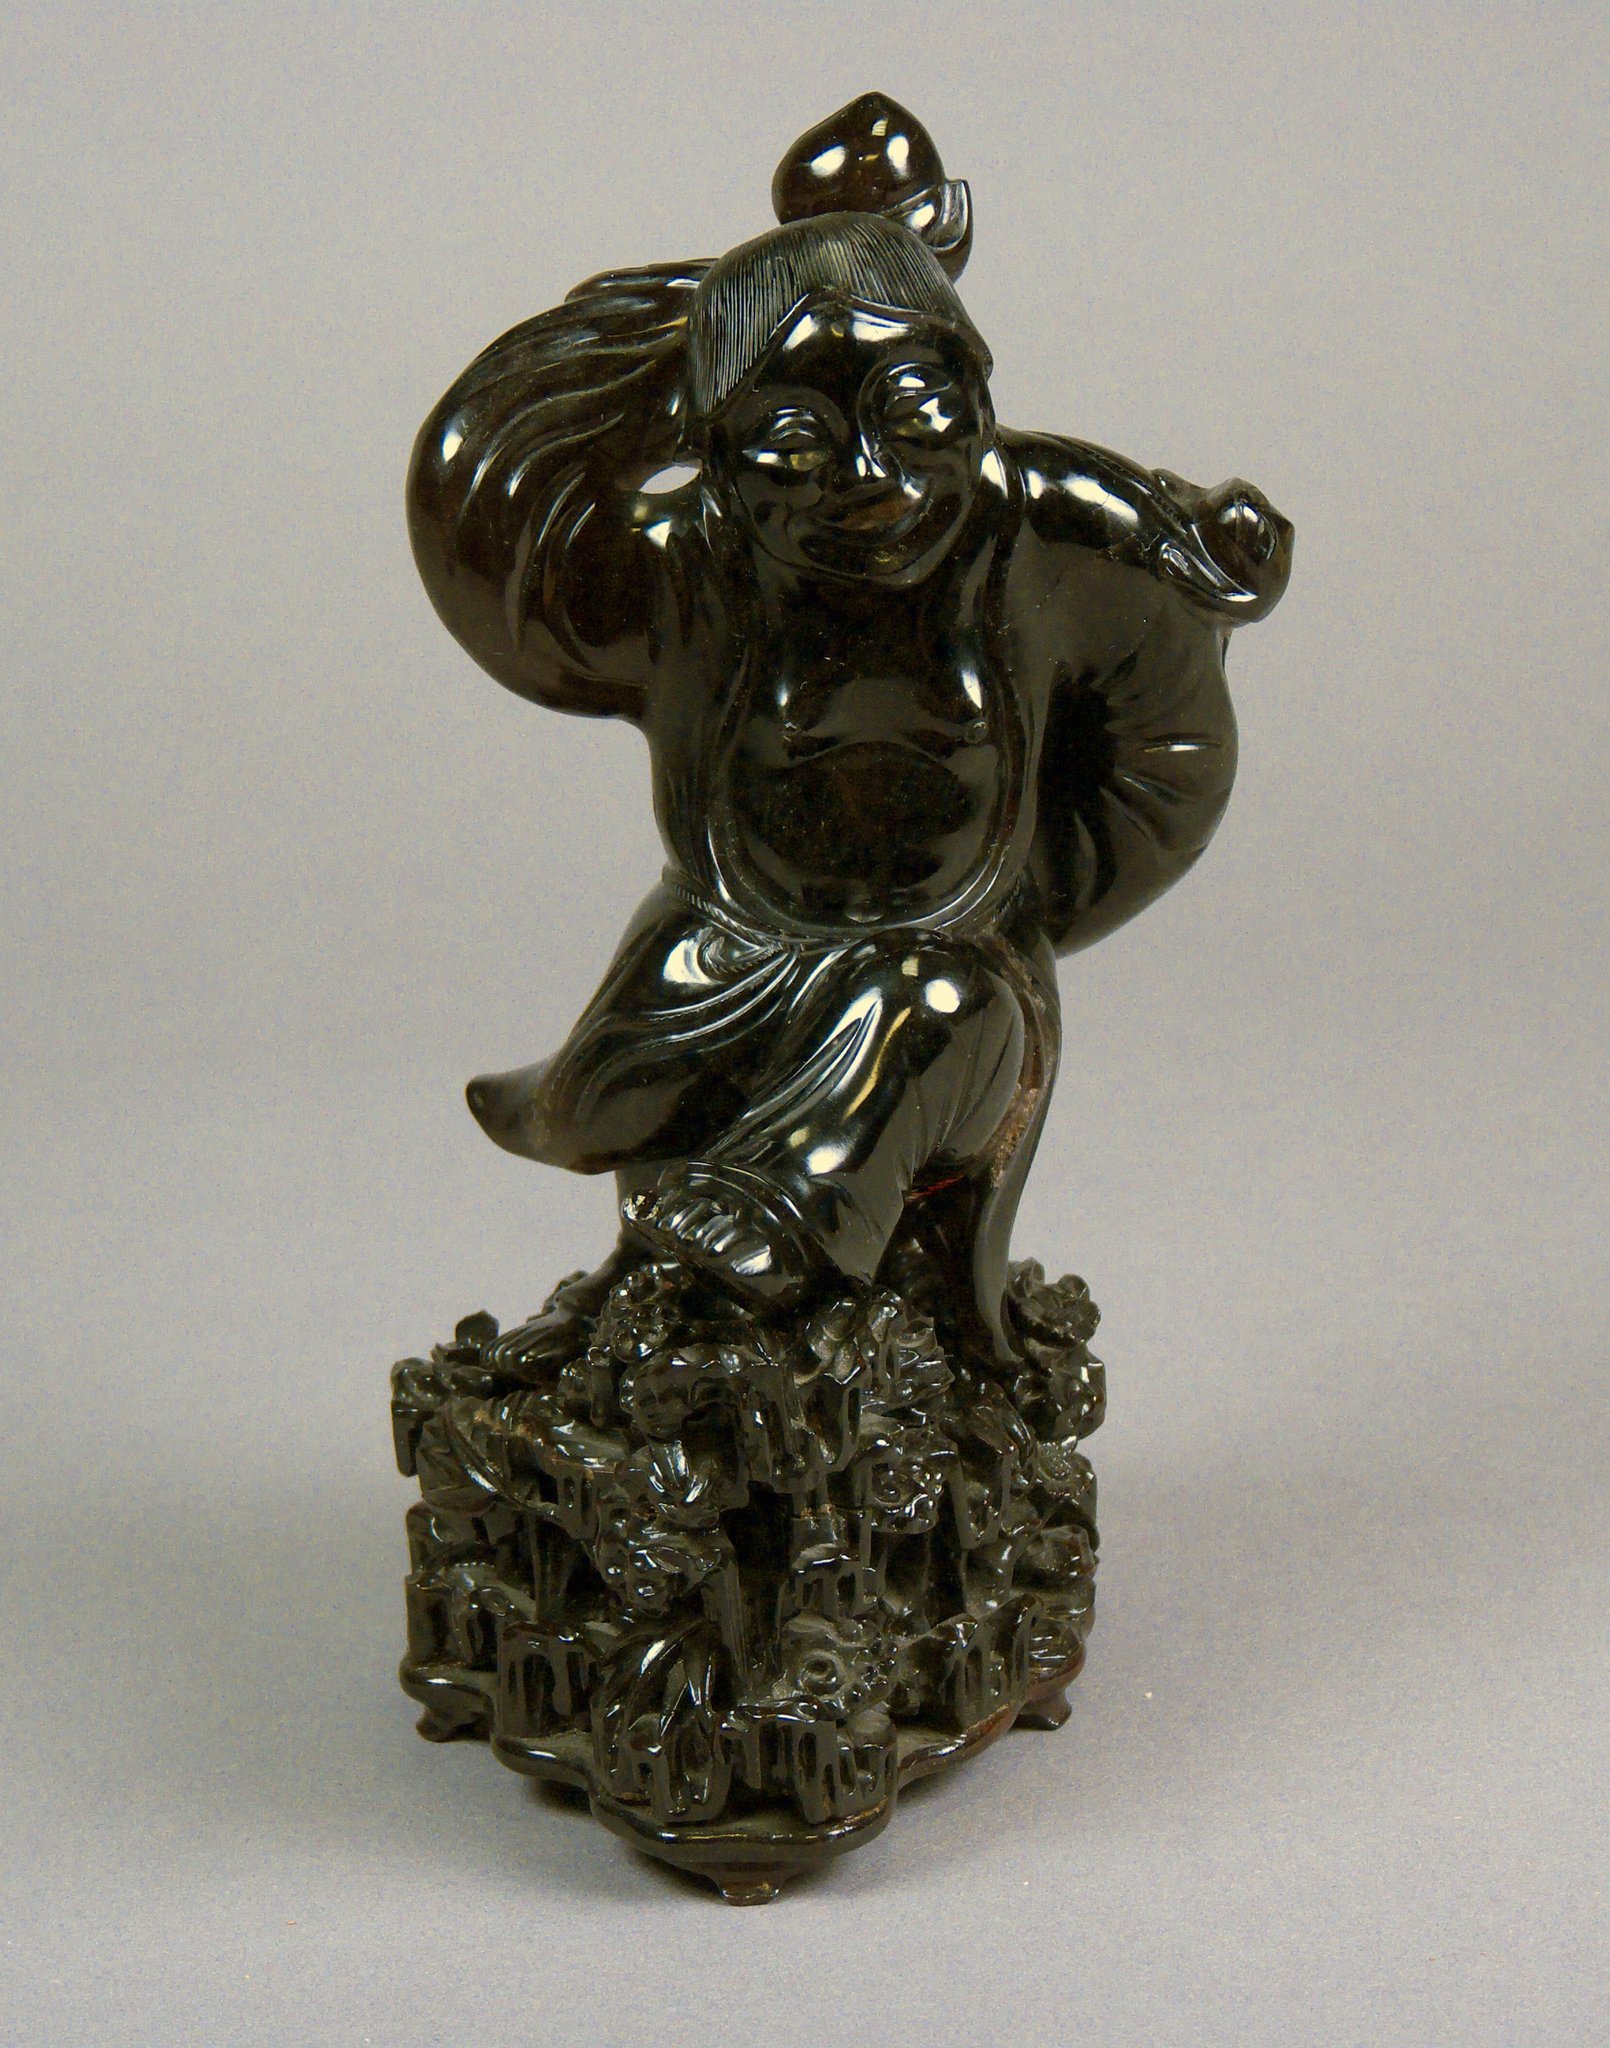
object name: figure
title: Daoist Immortal Liu Hai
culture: chinese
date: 1701-1900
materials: quartz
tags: men,daoism